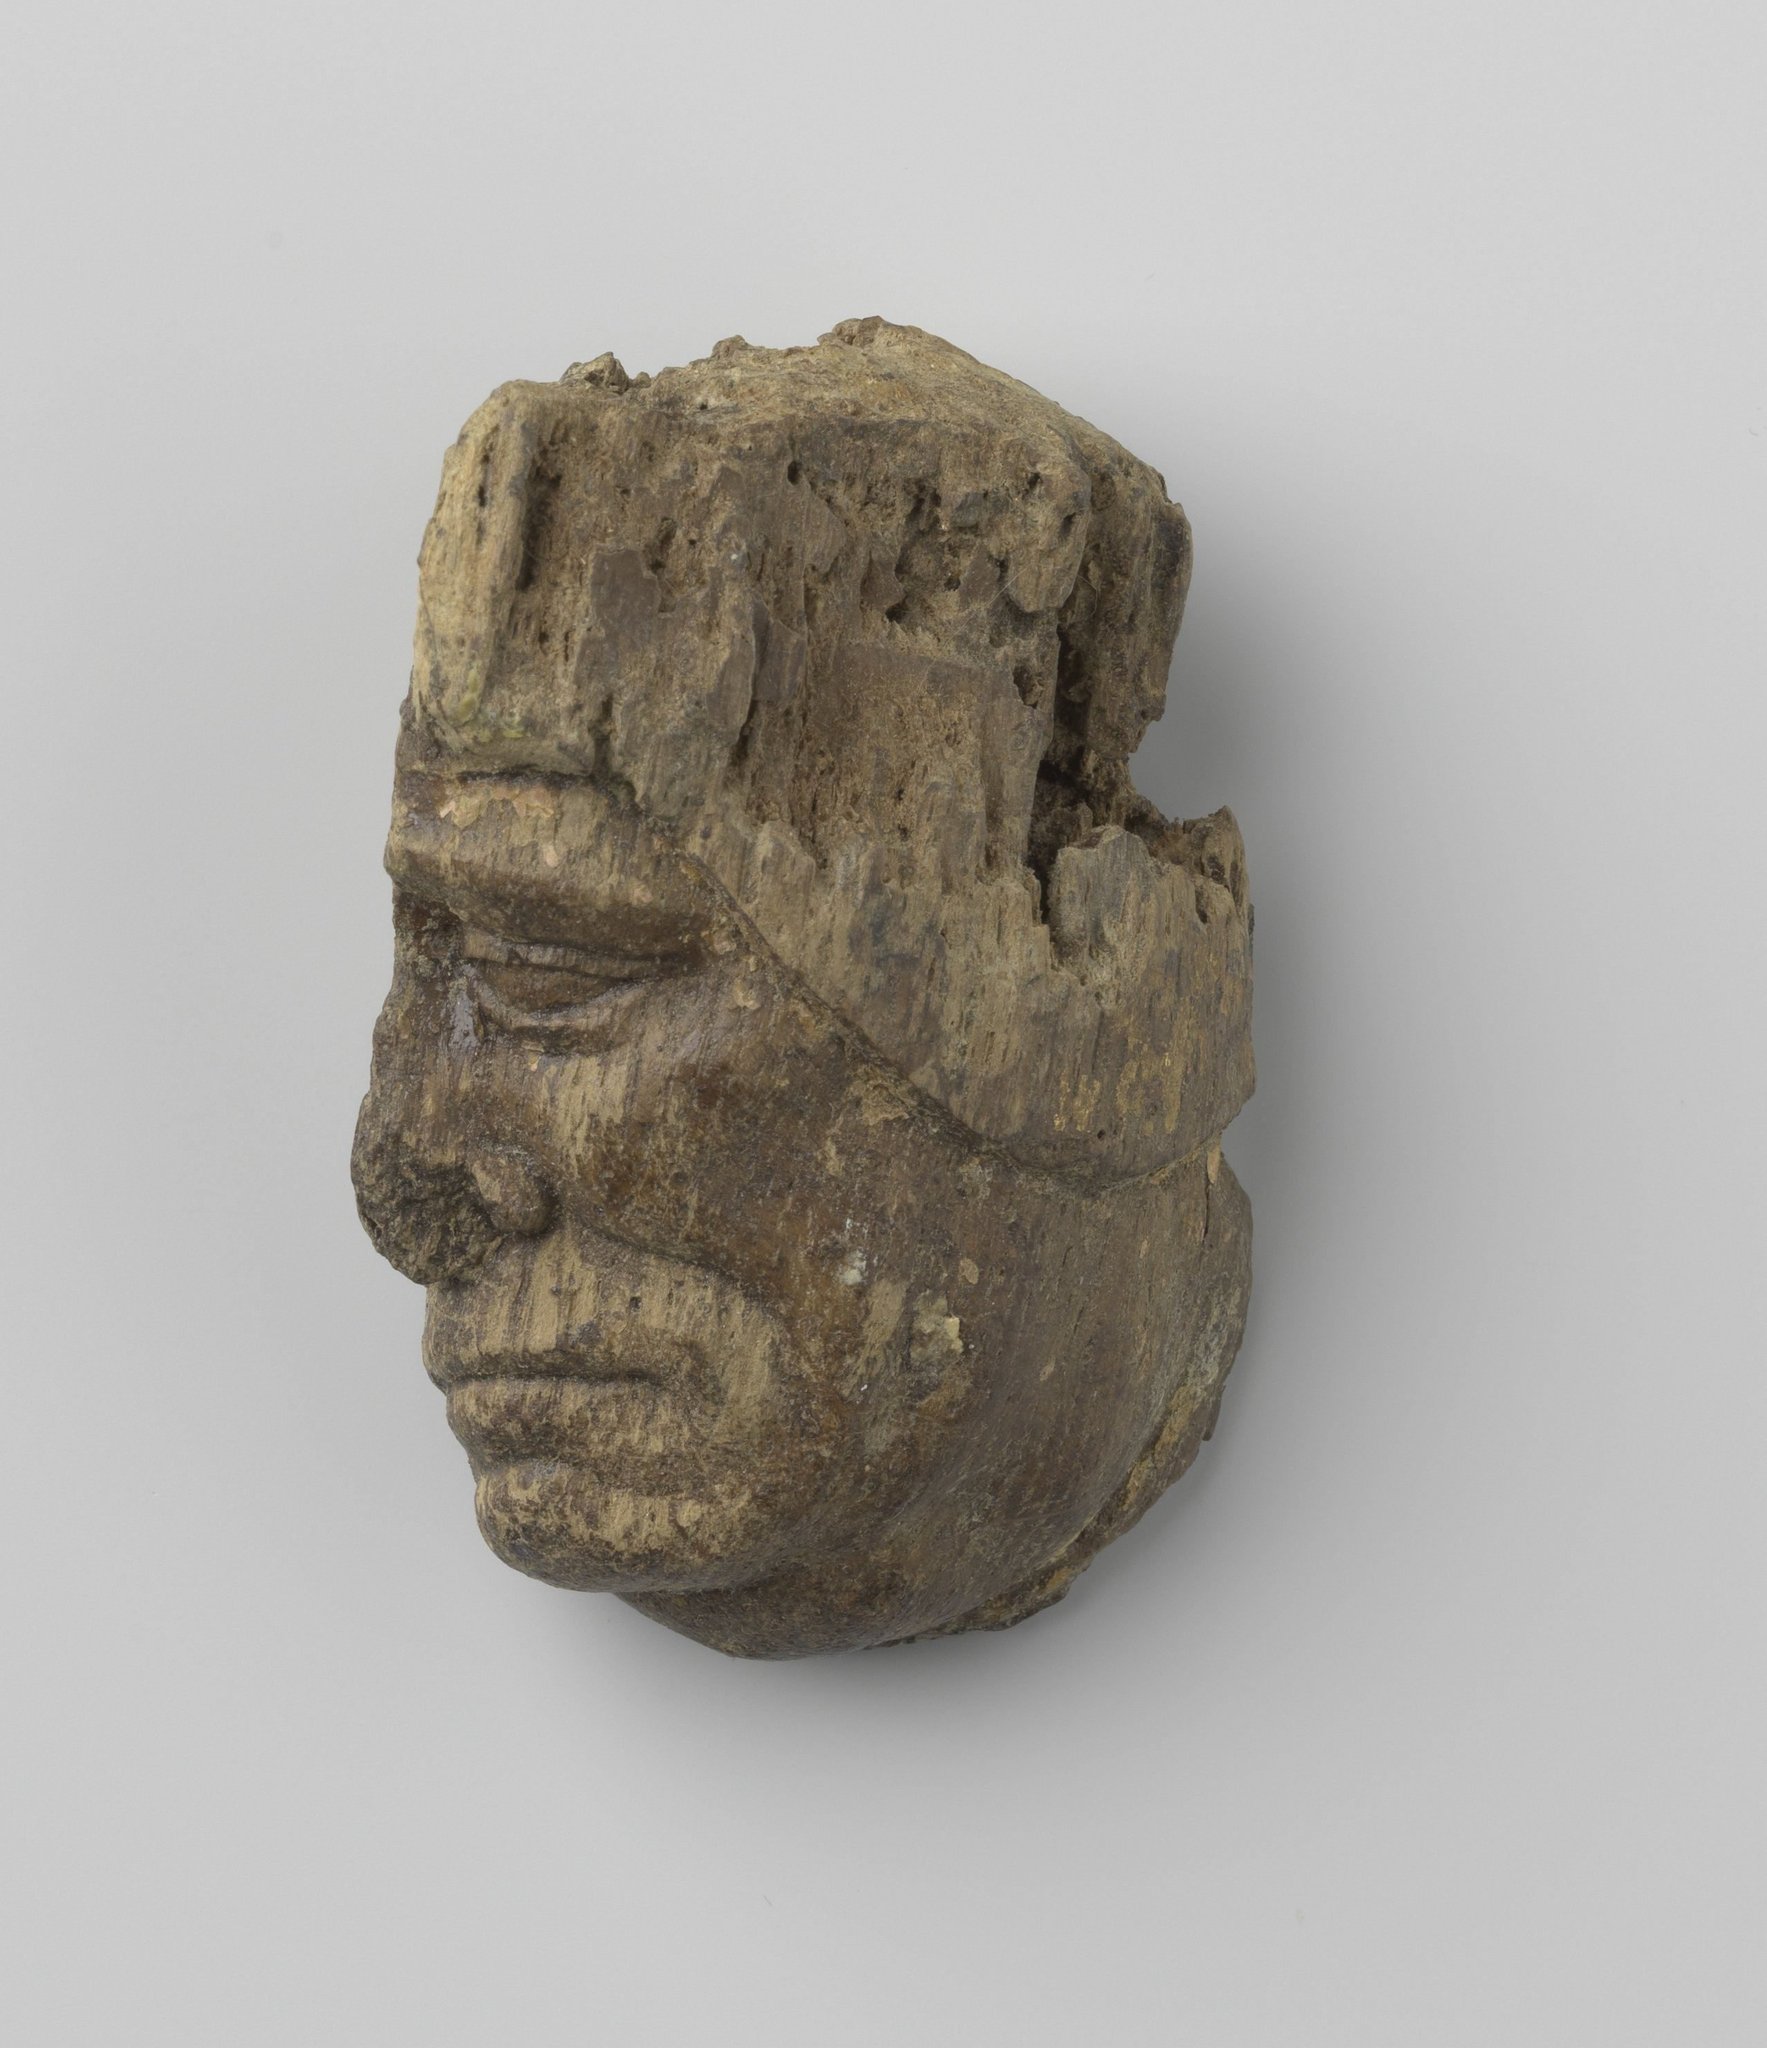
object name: sculpture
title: Fragment van een mannenhoofd; (mogelijk) behorend tot het retabel van Soest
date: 1475-1499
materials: wood